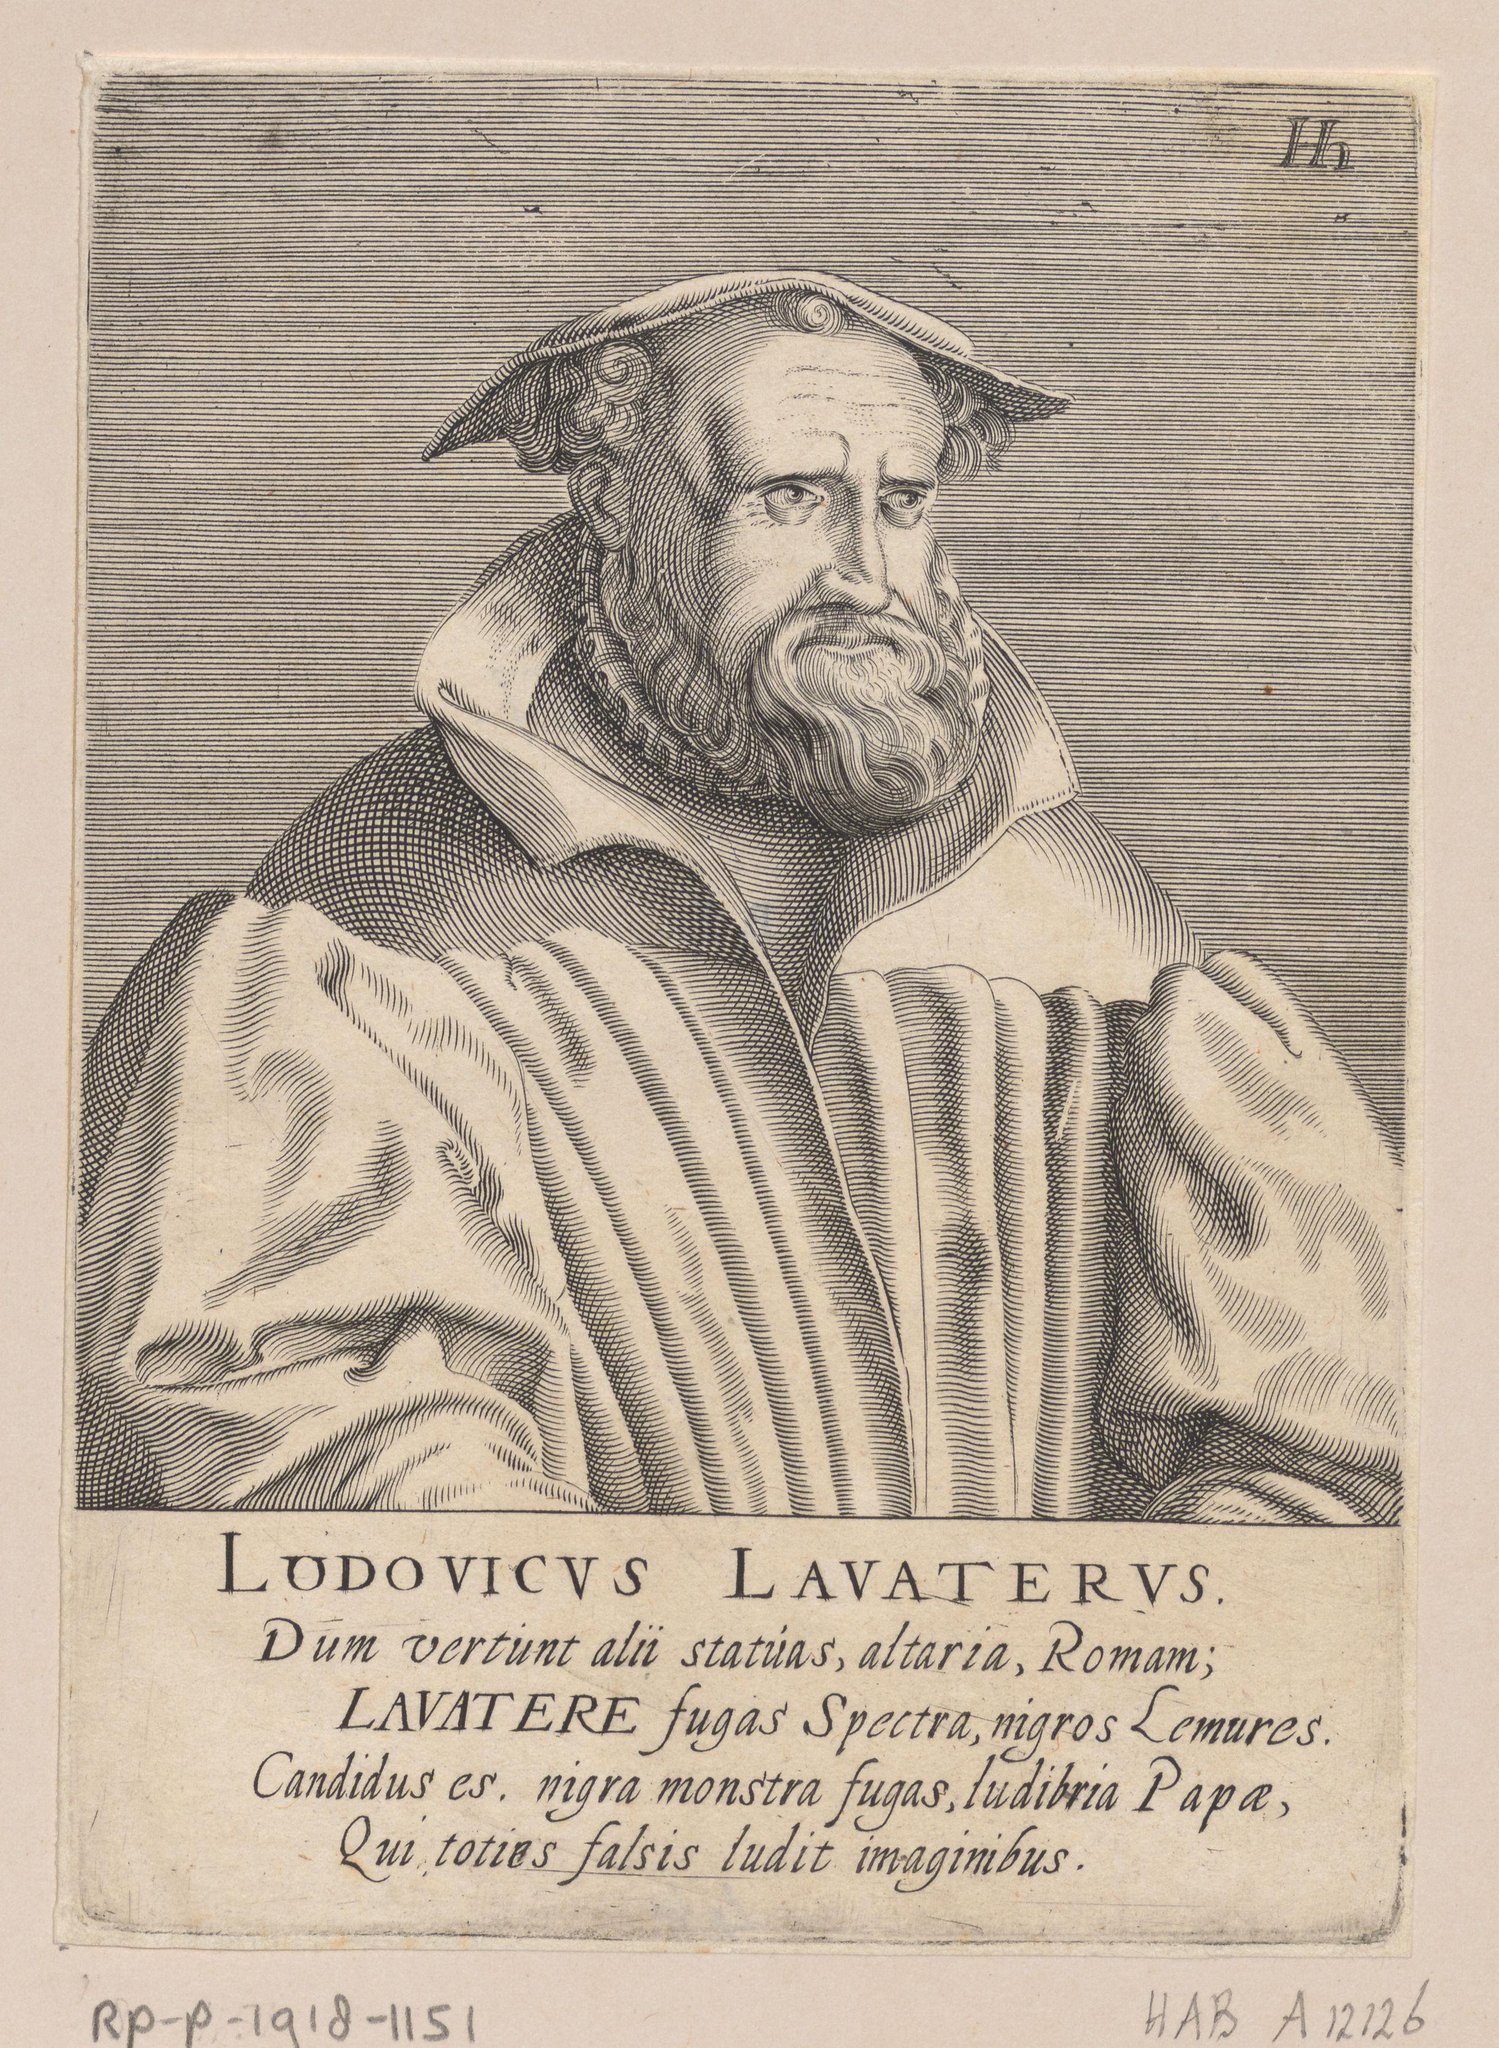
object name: print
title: Beroemde hervormers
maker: hendrick hondius (i)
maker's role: draughtsman, print maker, publisher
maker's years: 1573-1650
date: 1599-1604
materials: paper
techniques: engraving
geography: the hague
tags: theologian, historical persons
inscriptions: collector's mark: Lugt 2233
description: Prent uit (deel 1 van) de serie portretten van beroemde hervormers, 1599. Prent is ook gebruikt in de edities uit 1602 en 1604.